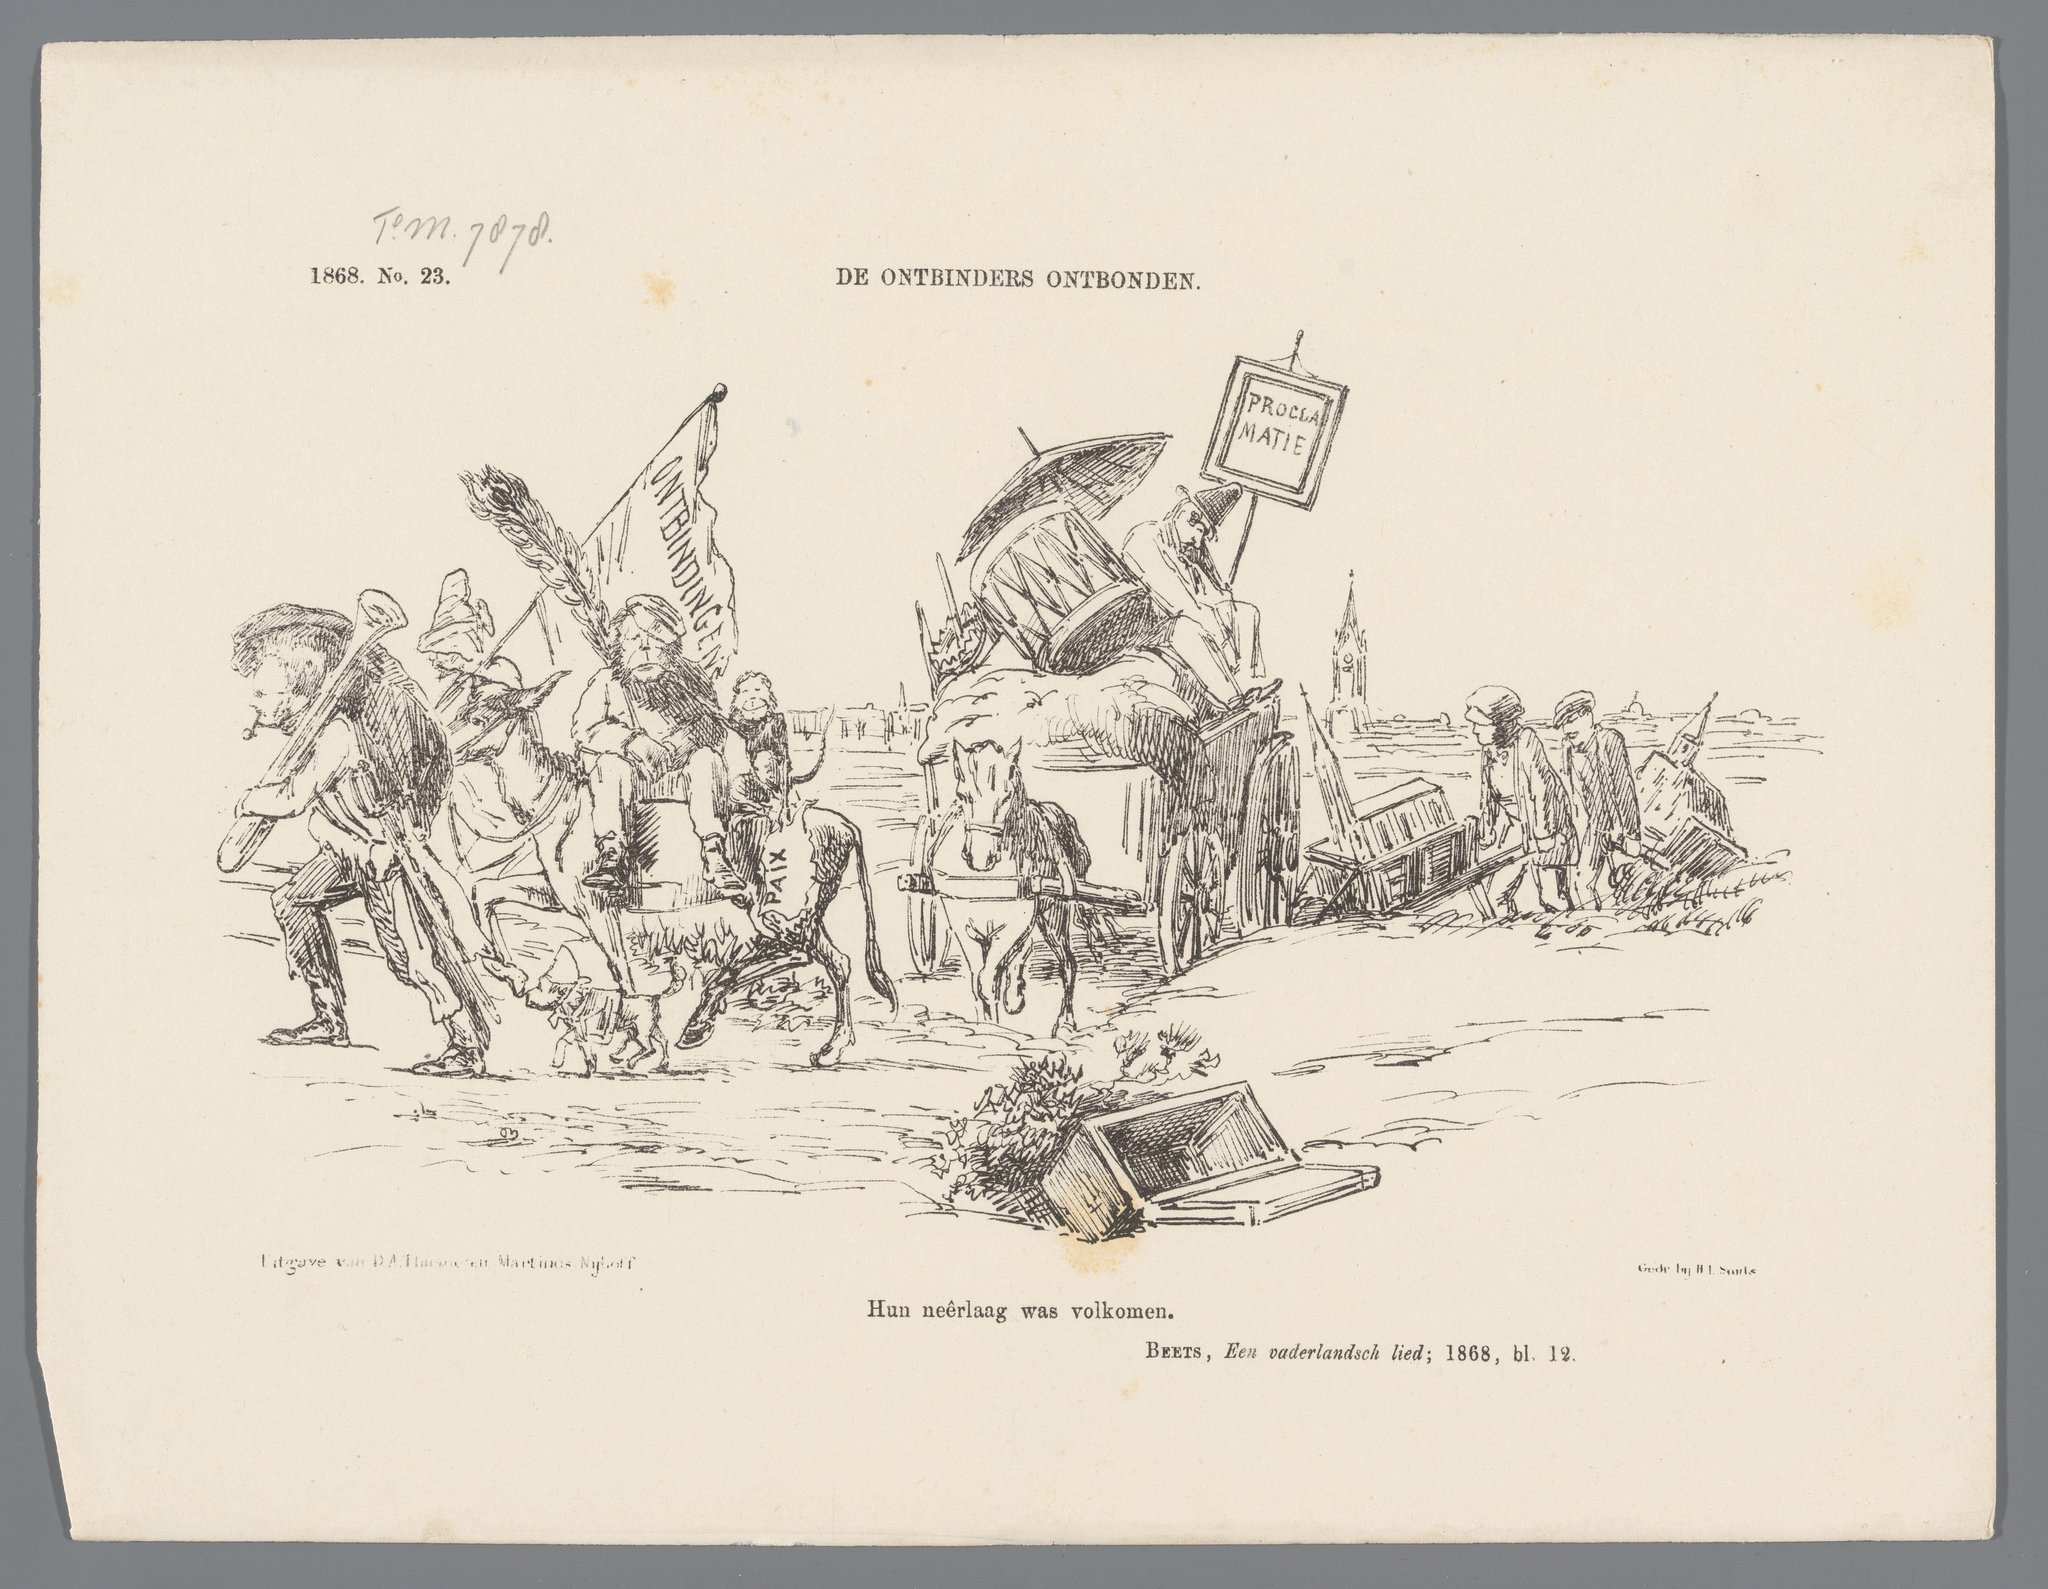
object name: cartoon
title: Spotprent met het vertrek van de leden van het oude kabinet, 1868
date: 1867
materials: paper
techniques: lithograph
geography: netherlands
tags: 43a38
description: Spotprent met de leden van het oude kabinet die als kermislieden de stad in een optocht verlaten. Plaat verschenen bij het weekblad De Nederlandsche Spectator, nr. 23, 6 juni 1868.